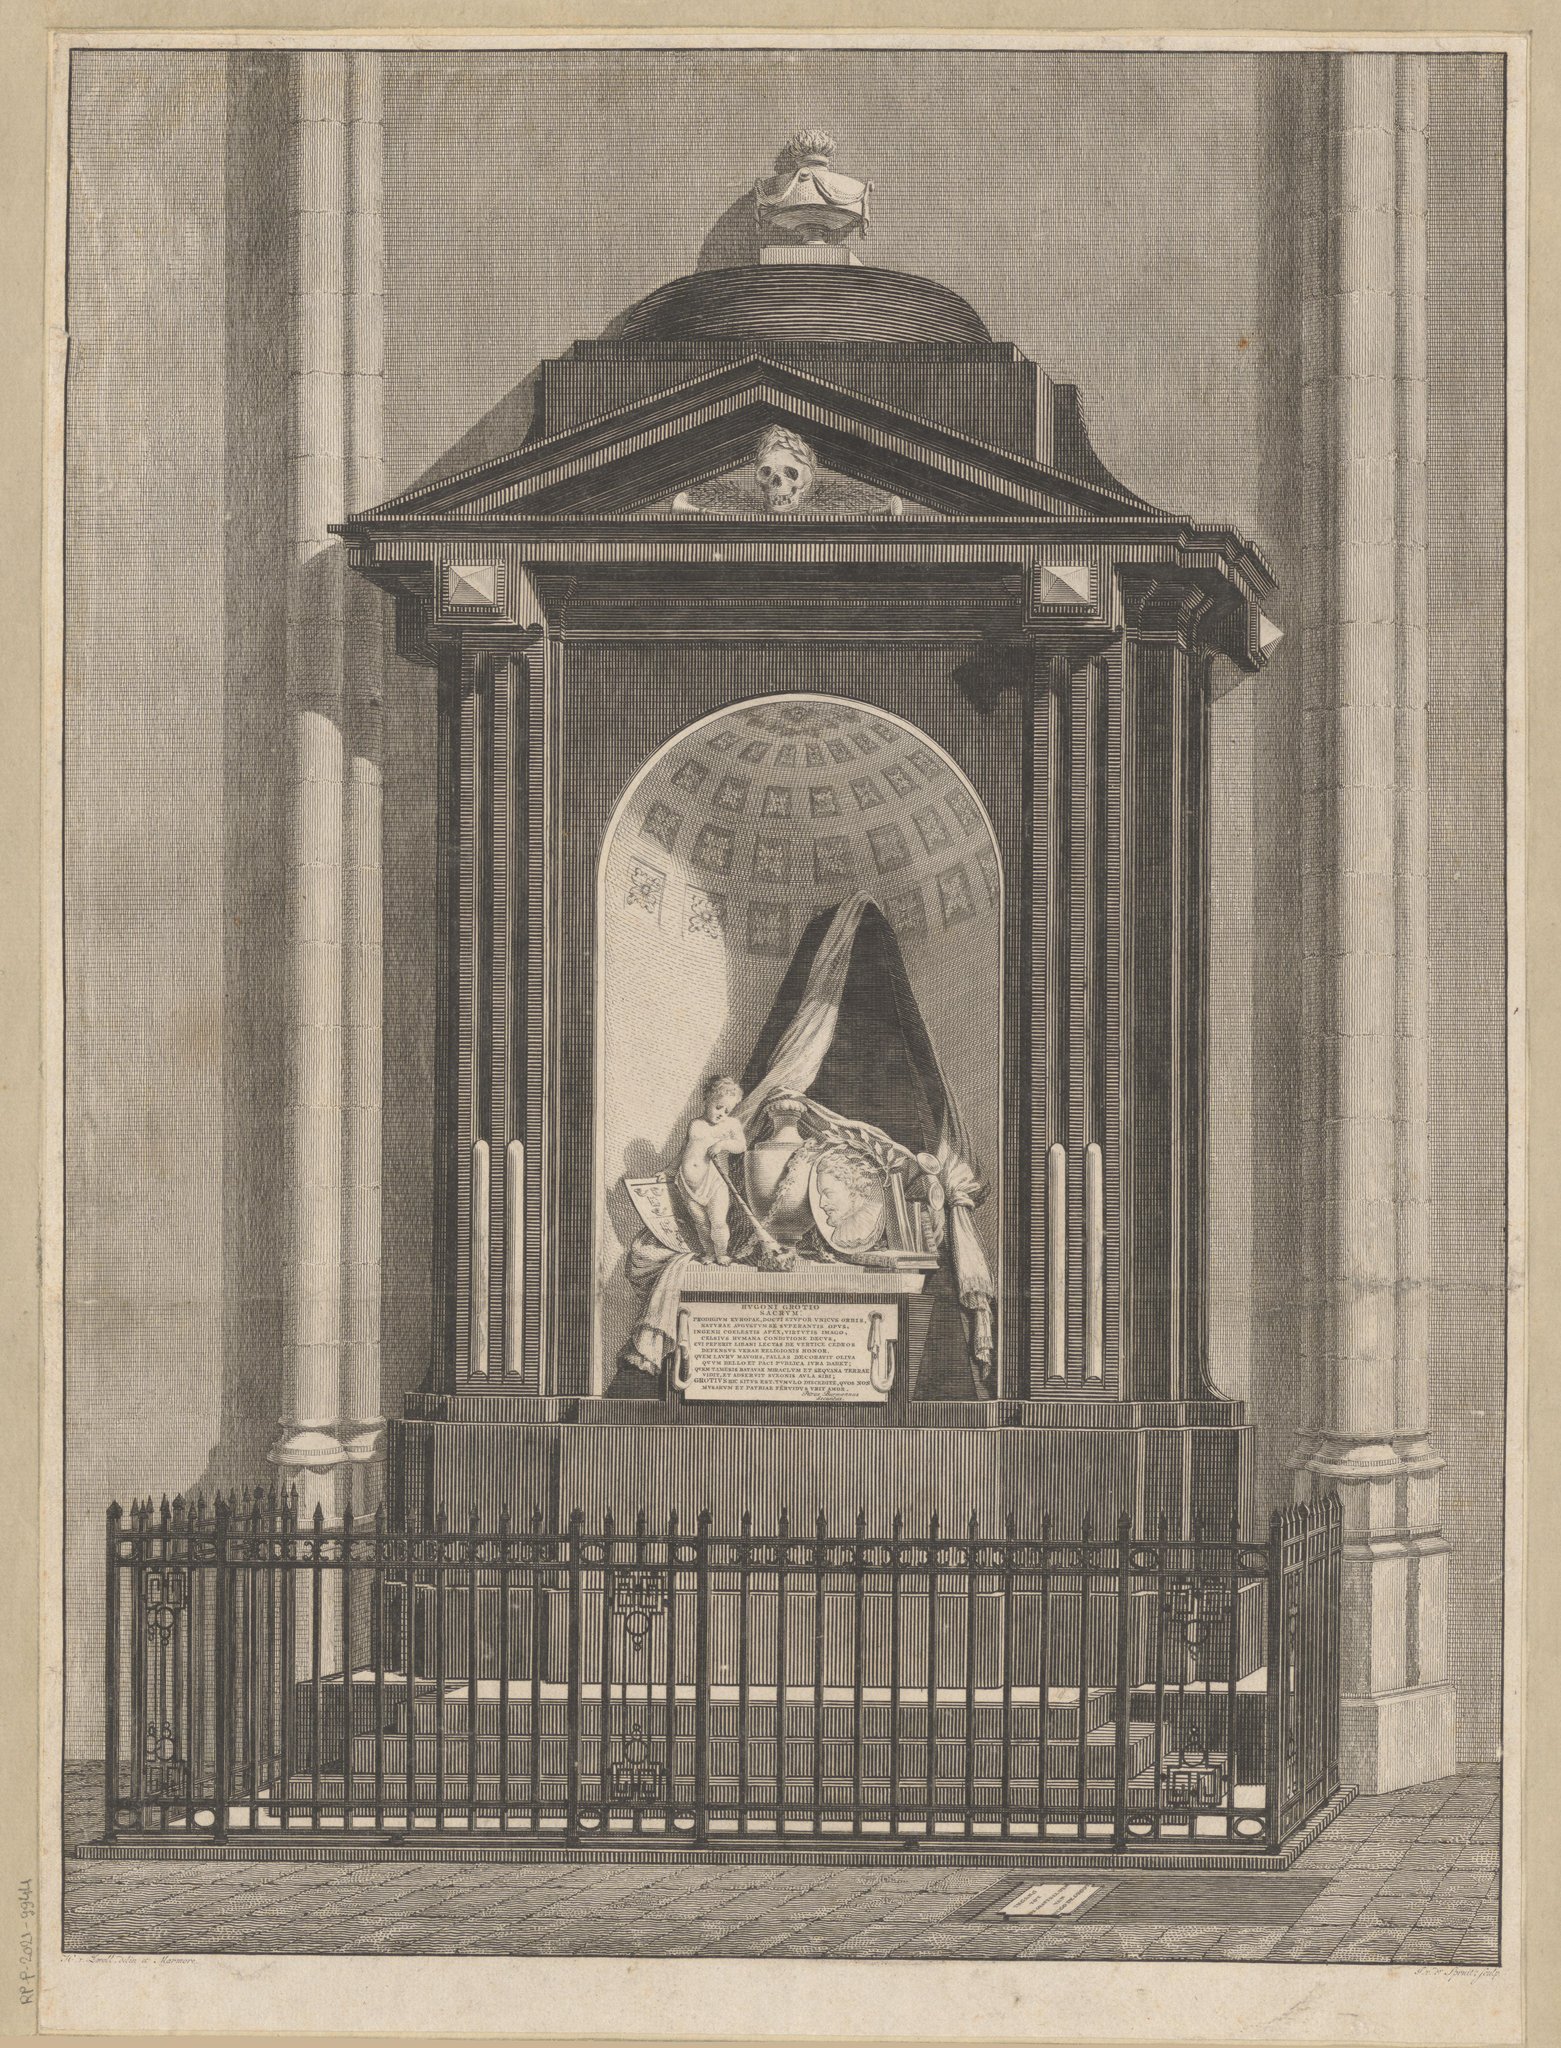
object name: print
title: Grafmonument van Hugo de Groot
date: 1781-1786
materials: paper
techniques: engraving, etching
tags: delft, hugo de groot, historical persons, grave, tomb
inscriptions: collector's mark: Lugt 964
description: Graftombe van Hugo de Groot, overleden 28 augustus 1645, in de Nieuwe Kerk te Delft. Monument opgericht door de familie van de overledene in 1781.